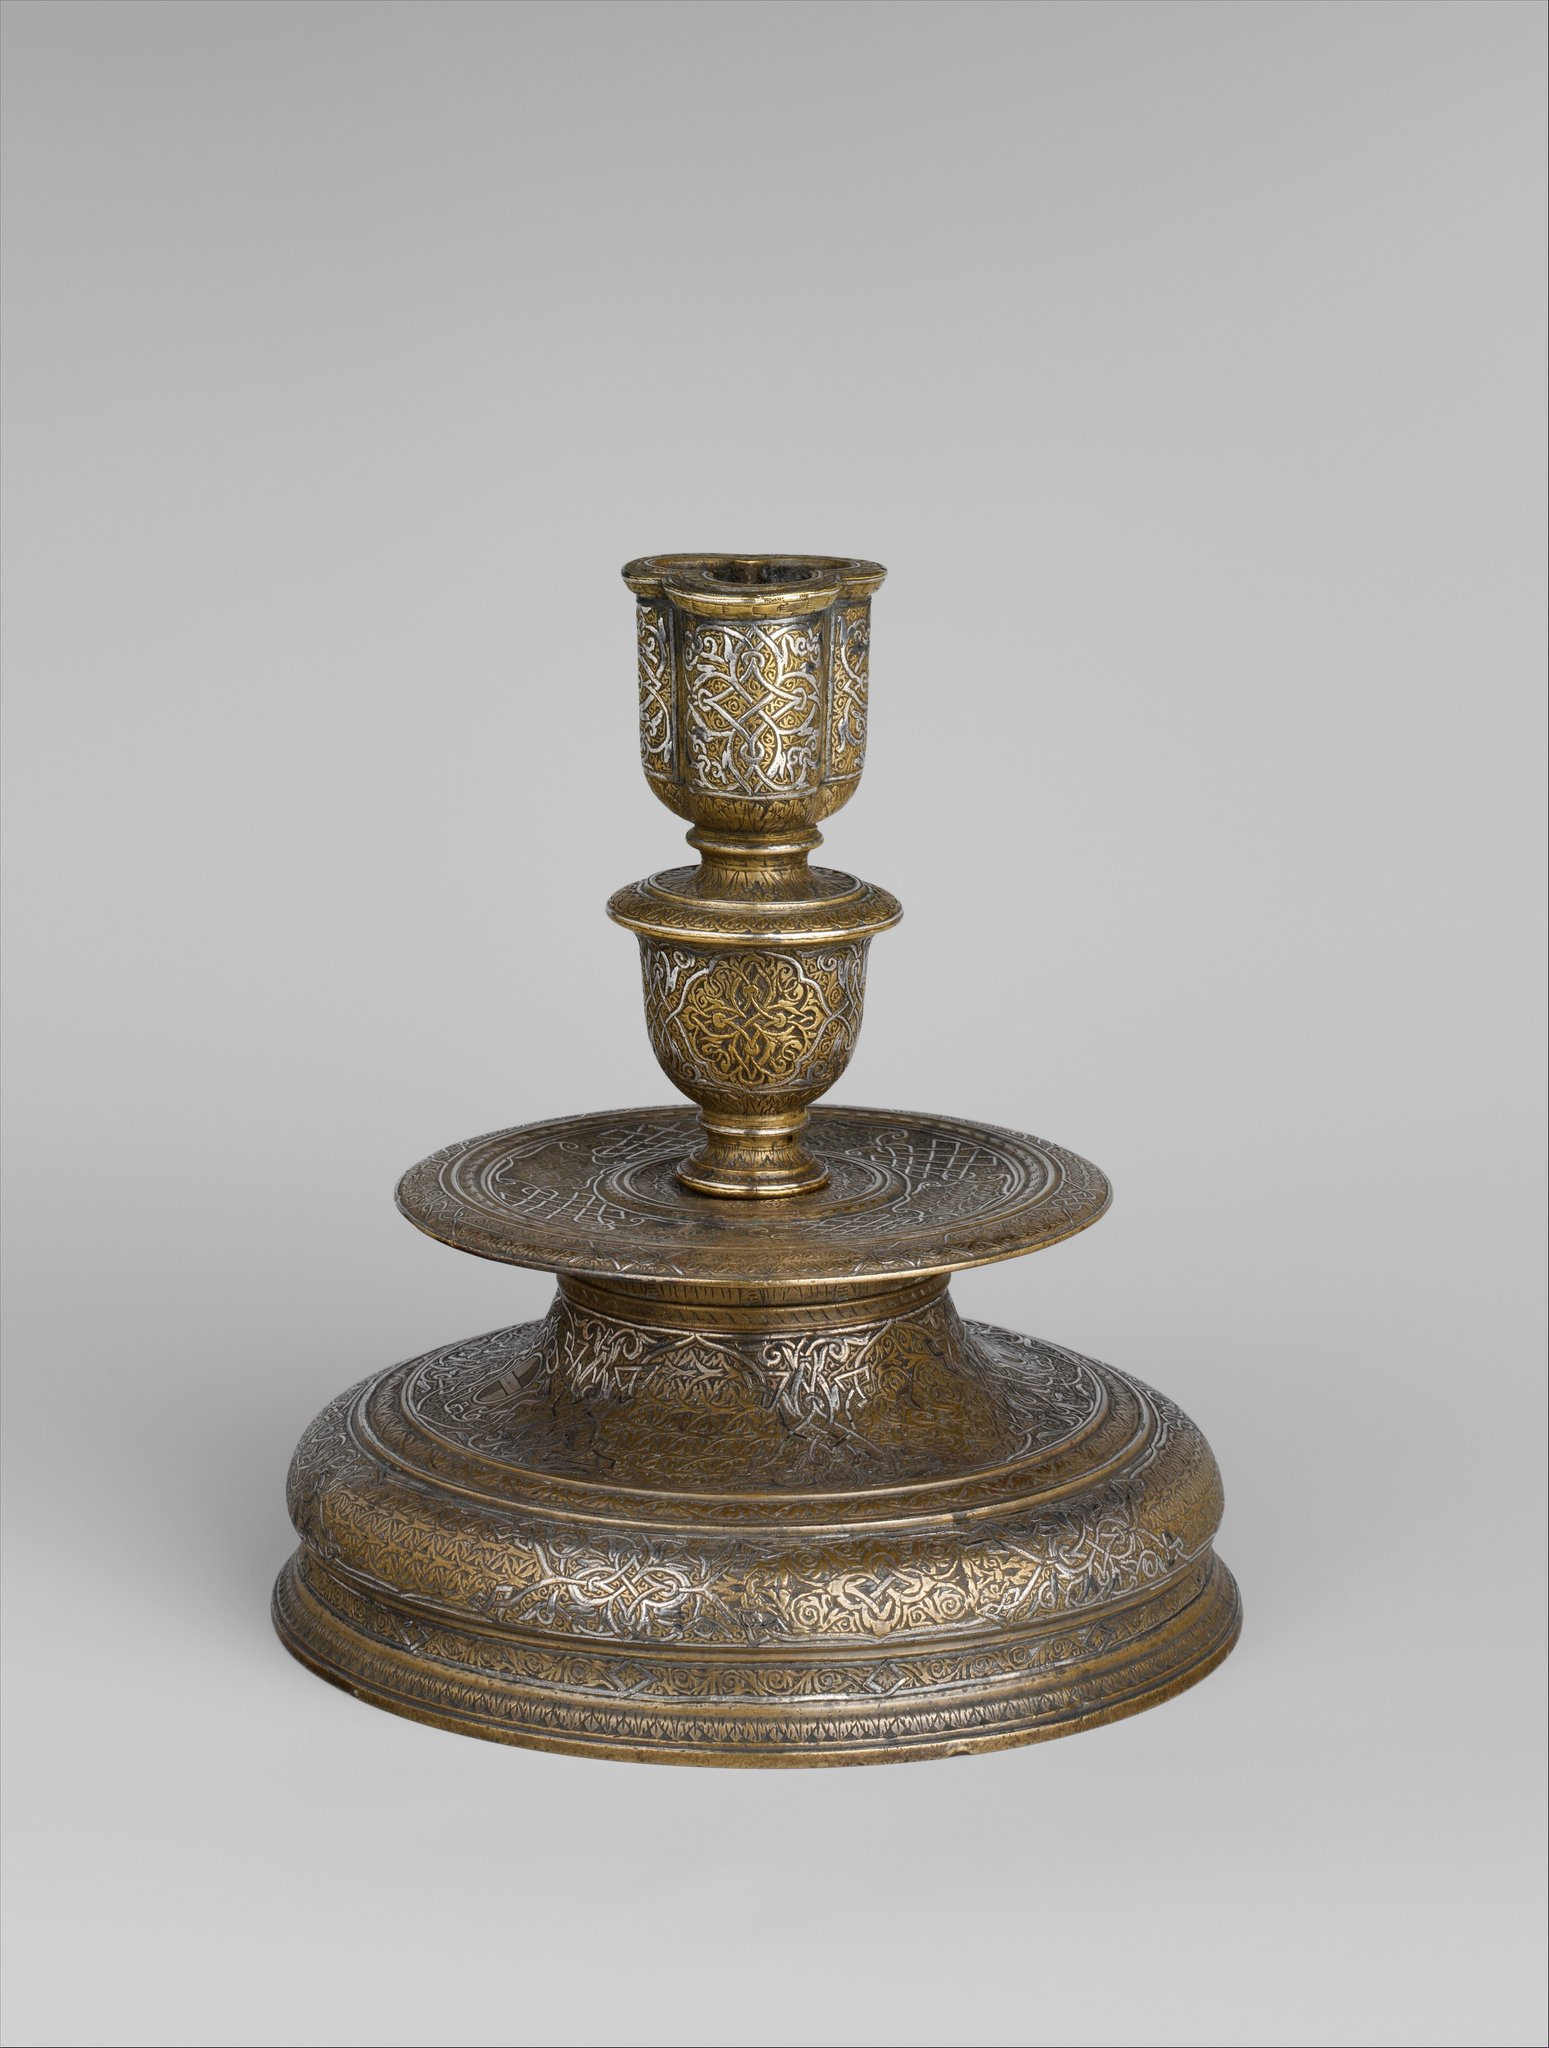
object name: candlestick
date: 1501-1600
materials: brass, silver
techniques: inlay